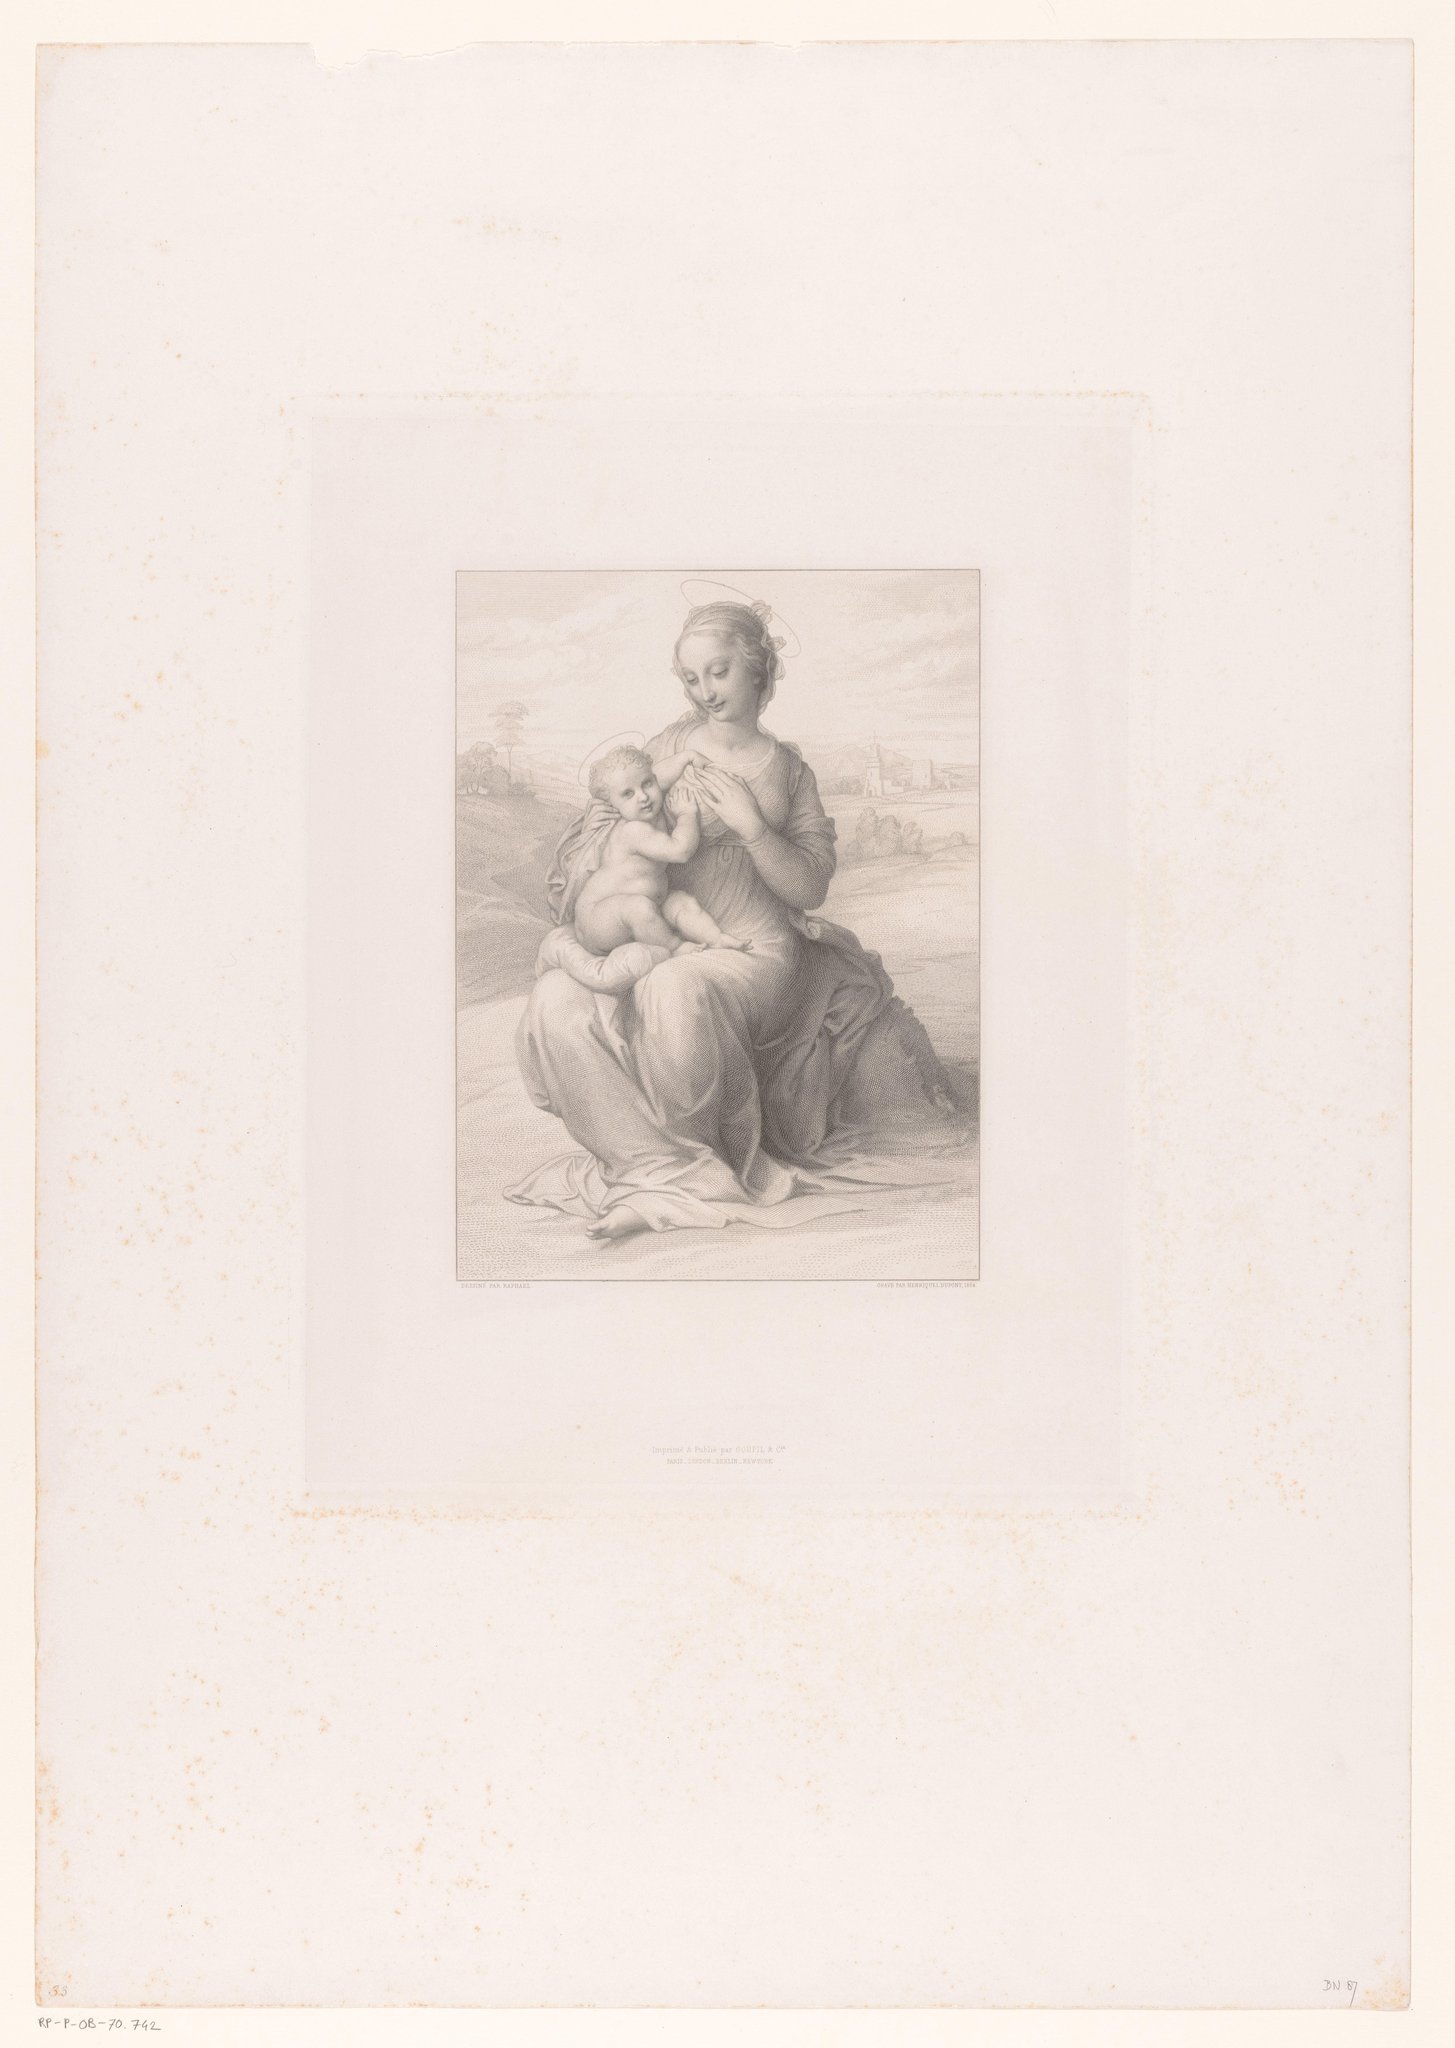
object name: print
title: Maria met Kind, zittend in een landschap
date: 1854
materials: paper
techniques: engraving, etching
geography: france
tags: madonna: mary sitting on the ground, the christ-child in her lap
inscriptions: collector's mark: Lugt 12